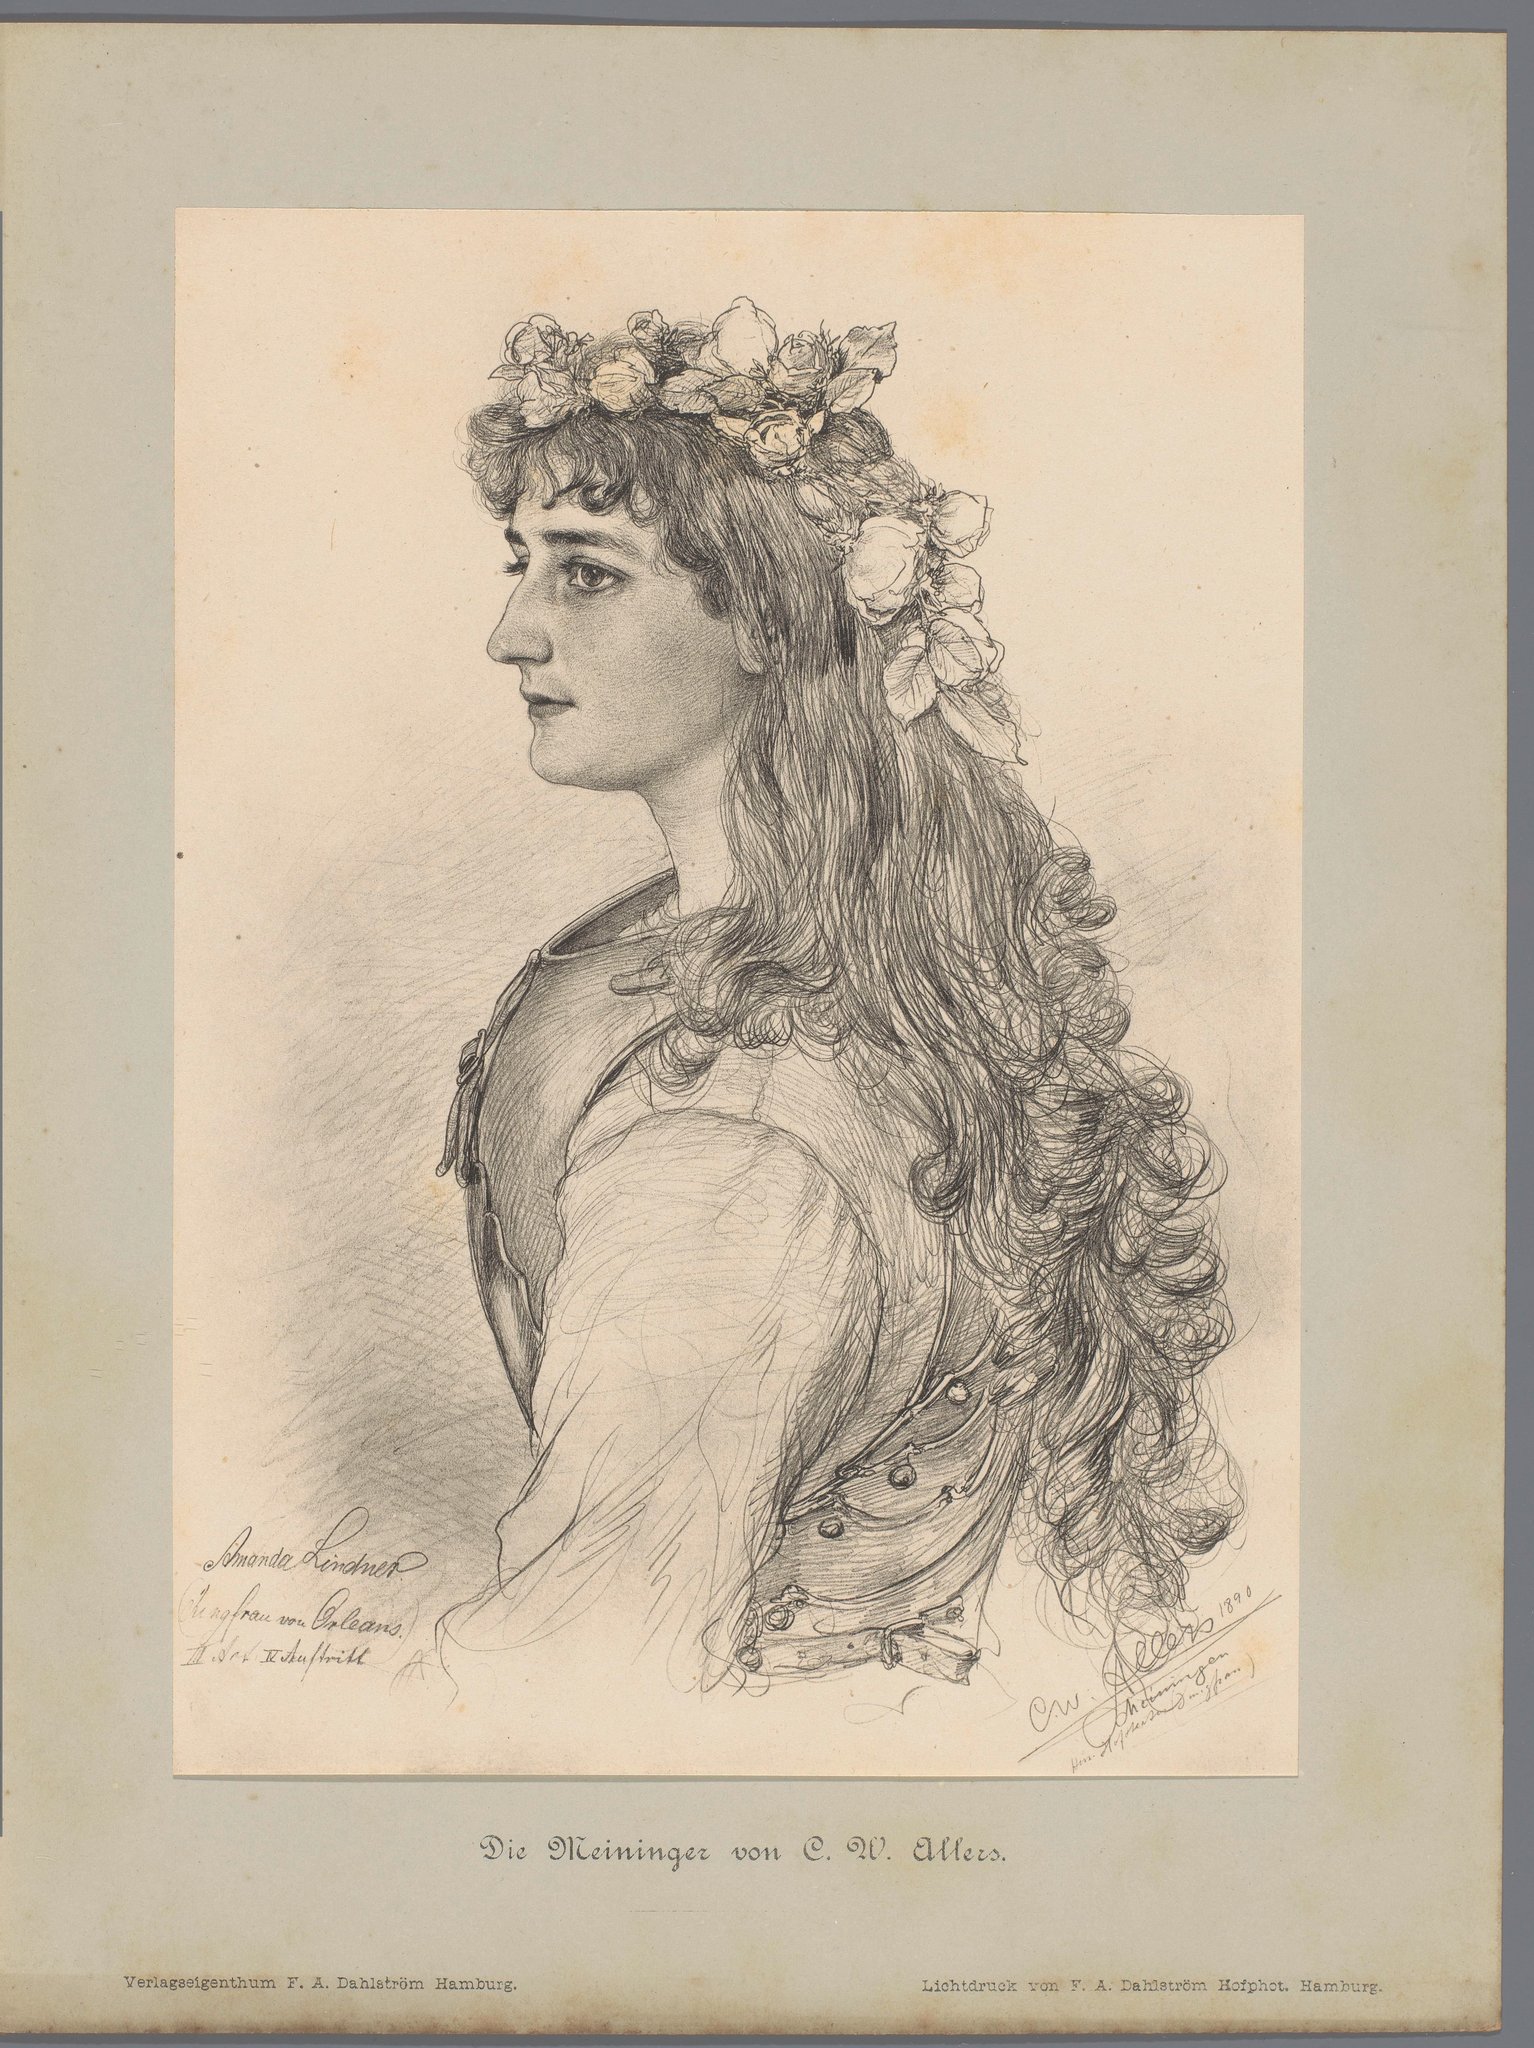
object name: photomechanical print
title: Fotoreproductie van een tekening, voorstellende een portret van Amanda Lindner als Jeanne d'Arc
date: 1890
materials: paper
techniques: photograph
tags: actress (on the stage), joan of arc (jeanne d'arc); possible attributes: armour, banner, lance, sword